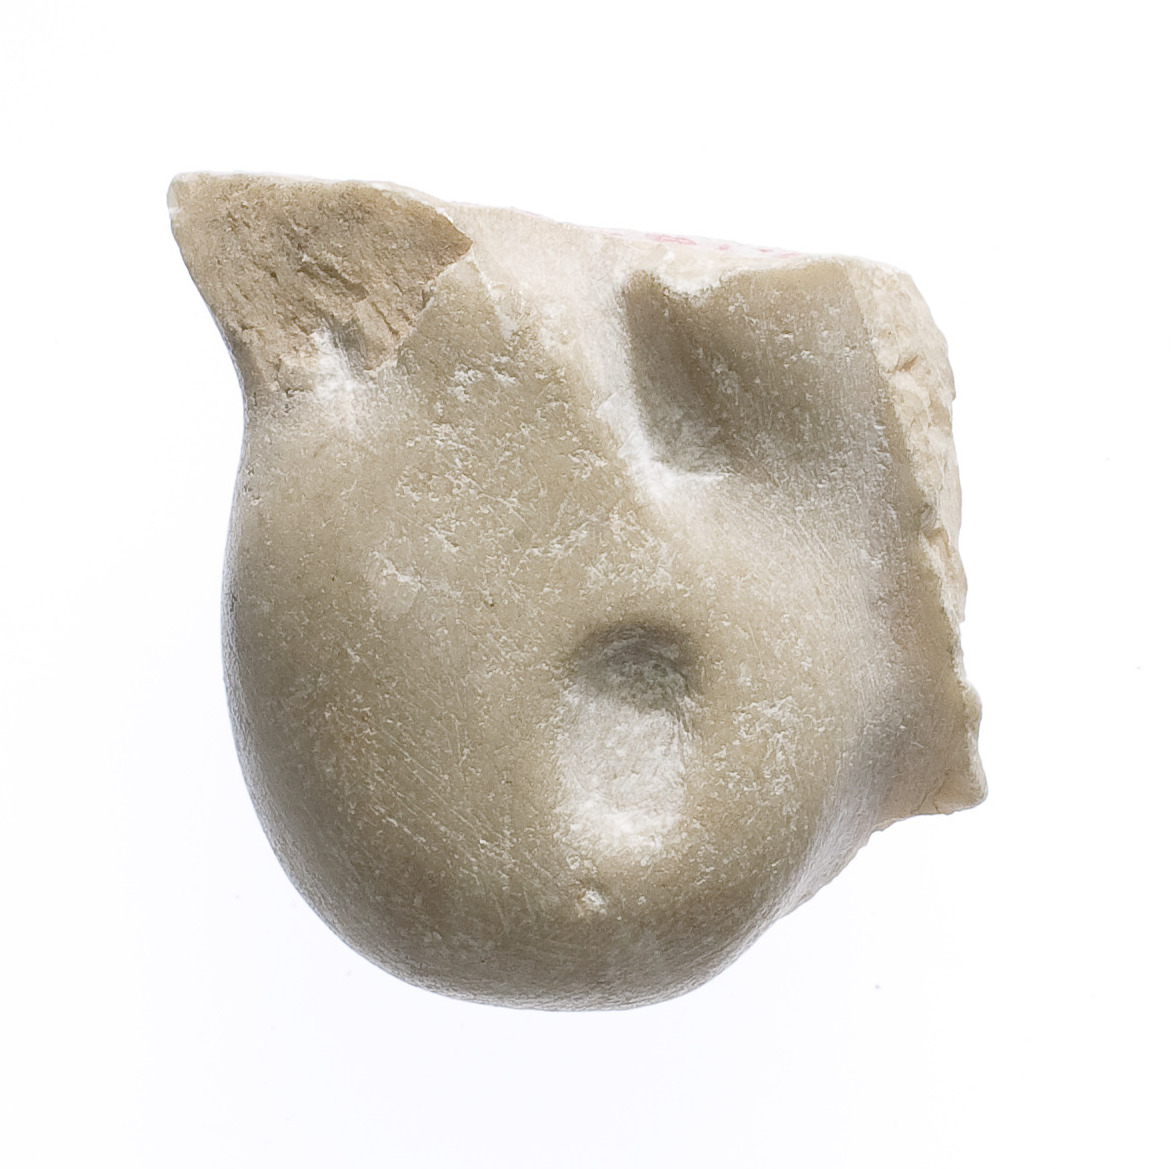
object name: head of akhenaten or nefertiti, ear lobe, pierced ear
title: Ear lobe from a statue of king or queen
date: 1353-1336 BCE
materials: limestone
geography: egypt